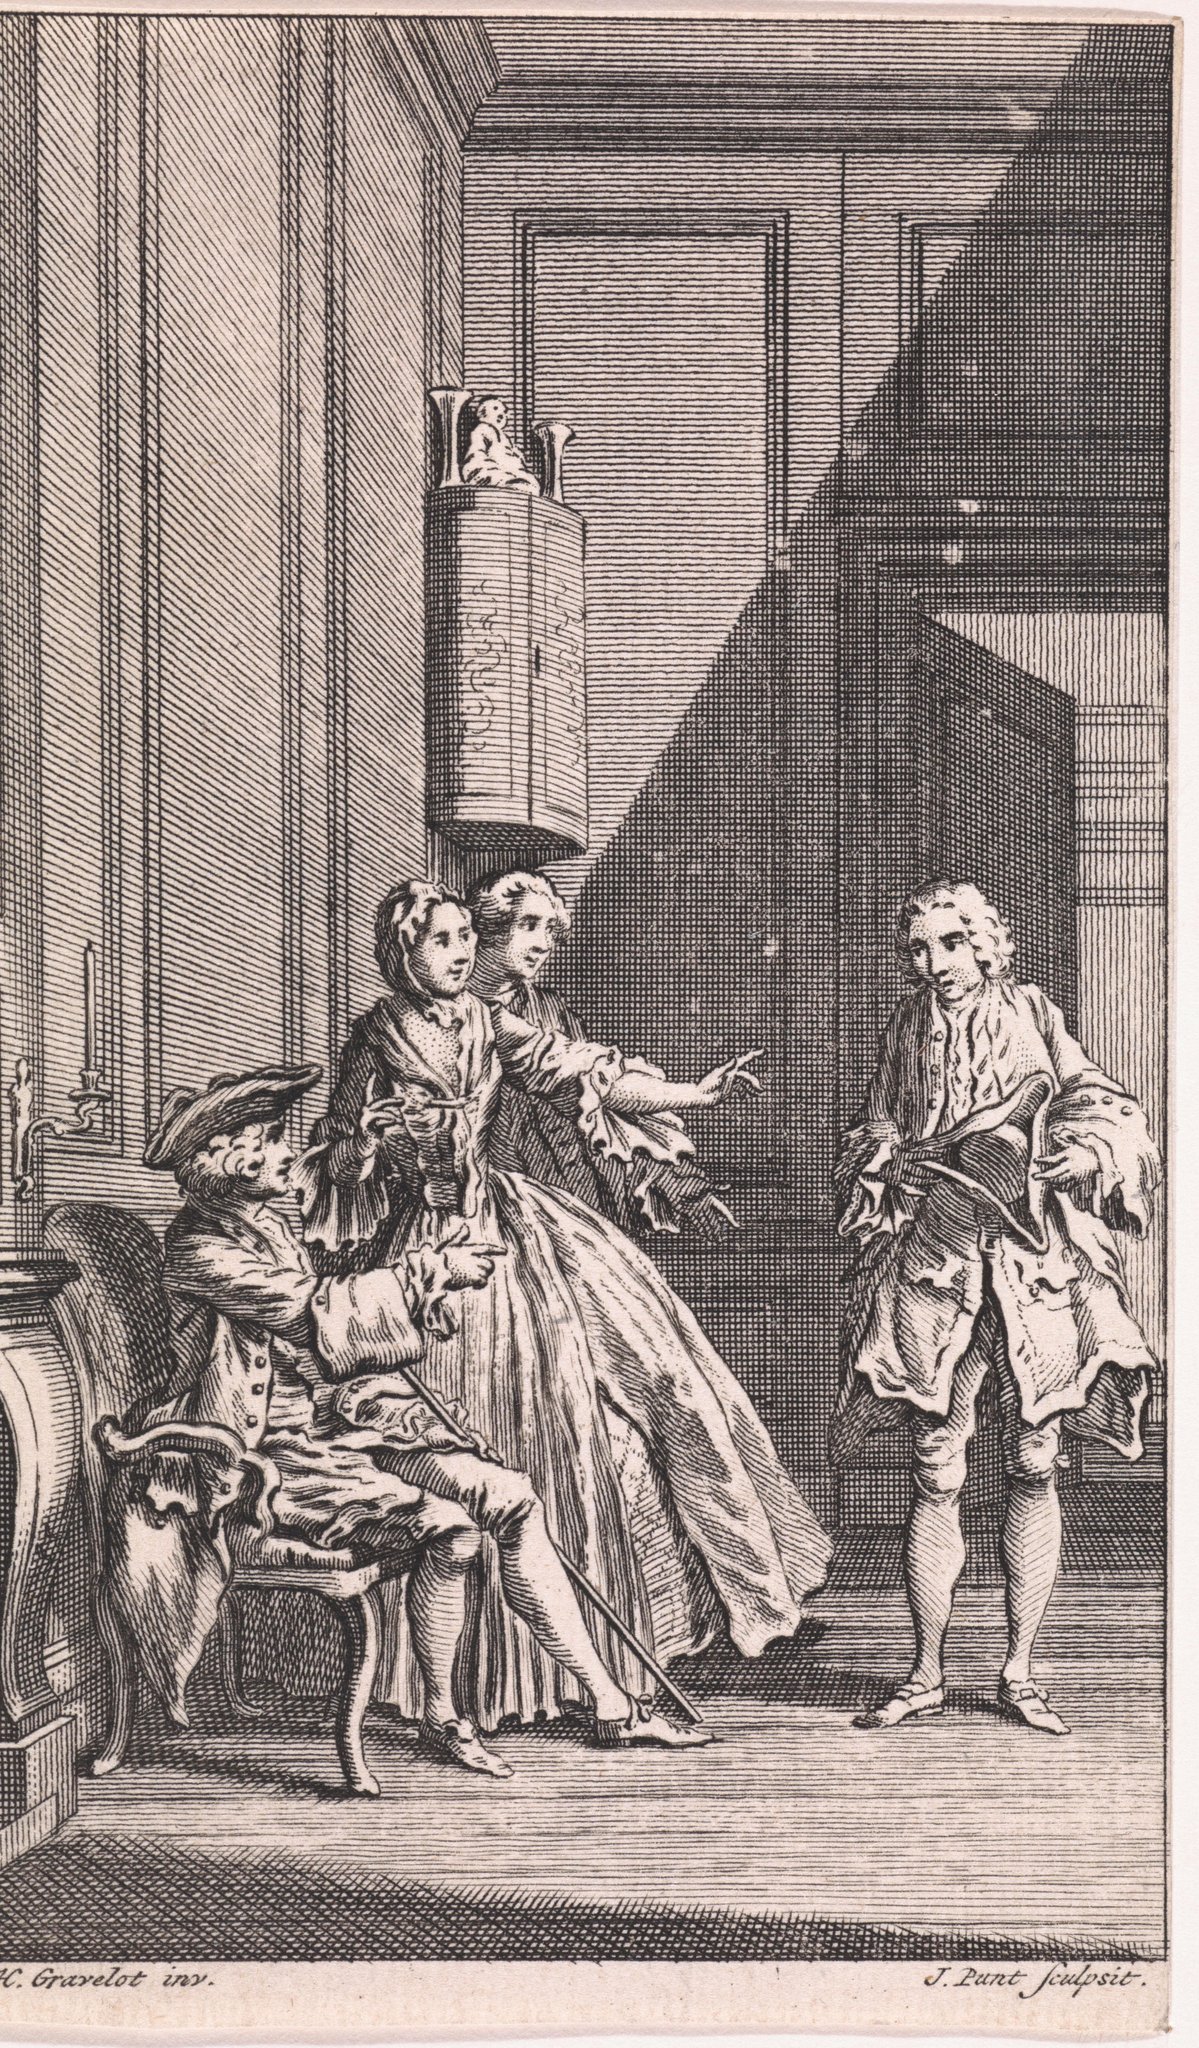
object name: book illustration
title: Alwaardij ontvangt Blisil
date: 1749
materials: paper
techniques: engraving, etching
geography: amsterdam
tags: specific works of literature, accusing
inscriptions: collector's mark: Lugt 2228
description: Prent gebruikt als illustratie in: Fielding, Henry. [Vertaald uit het Engels door] Pieter Le Clercq. Historie van den vondeling Tomas Jones, dl. 3, p. 484. Amsterdam: Gerrit de Groot, 1749.